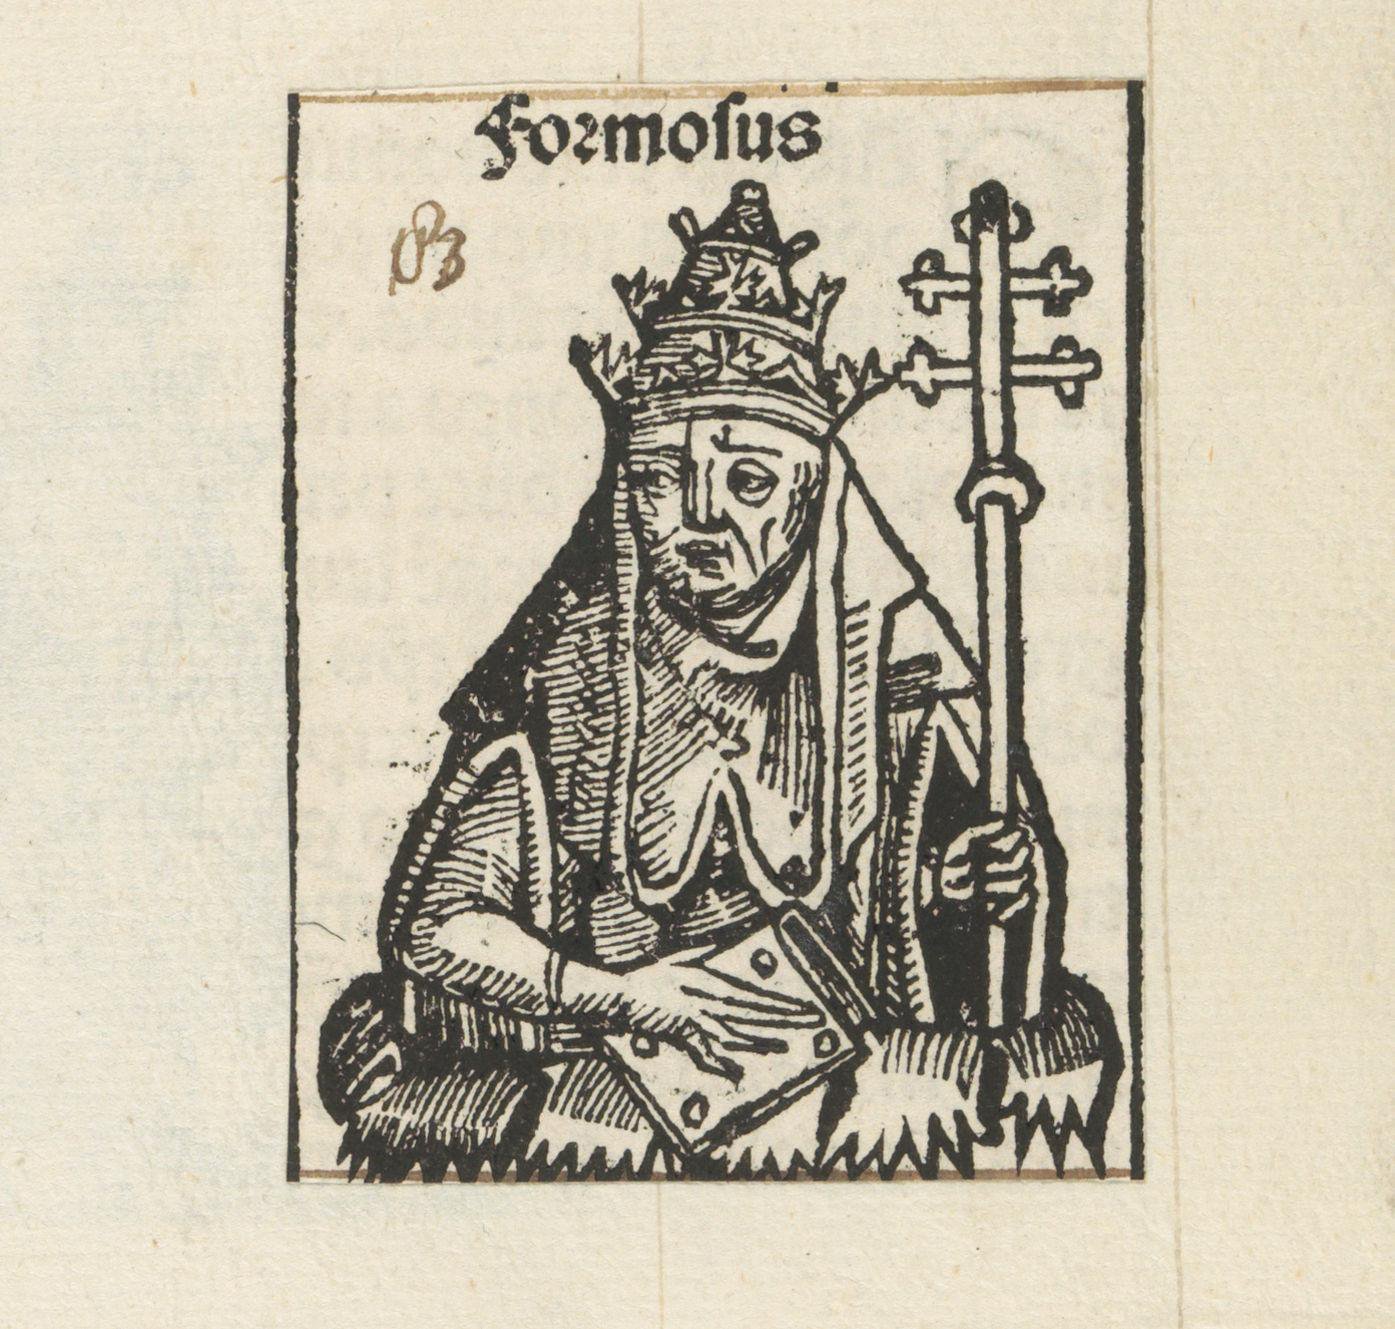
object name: print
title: Liber Chronicarum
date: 1493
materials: paper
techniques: letterpress printing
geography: nuremberg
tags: rome, pope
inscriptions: inscription: ‘83’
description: Een bloemkelk met een paus. Hij draagt een tiara en heeft een boek en een staf met een dubbel kruis in zijn handen. De voorstelling is onderdeel van de opeenvolging pausen in de Liber Chronicarum. De tekst identificeert de man als Formosus. De prent maakt deel uit van een album.